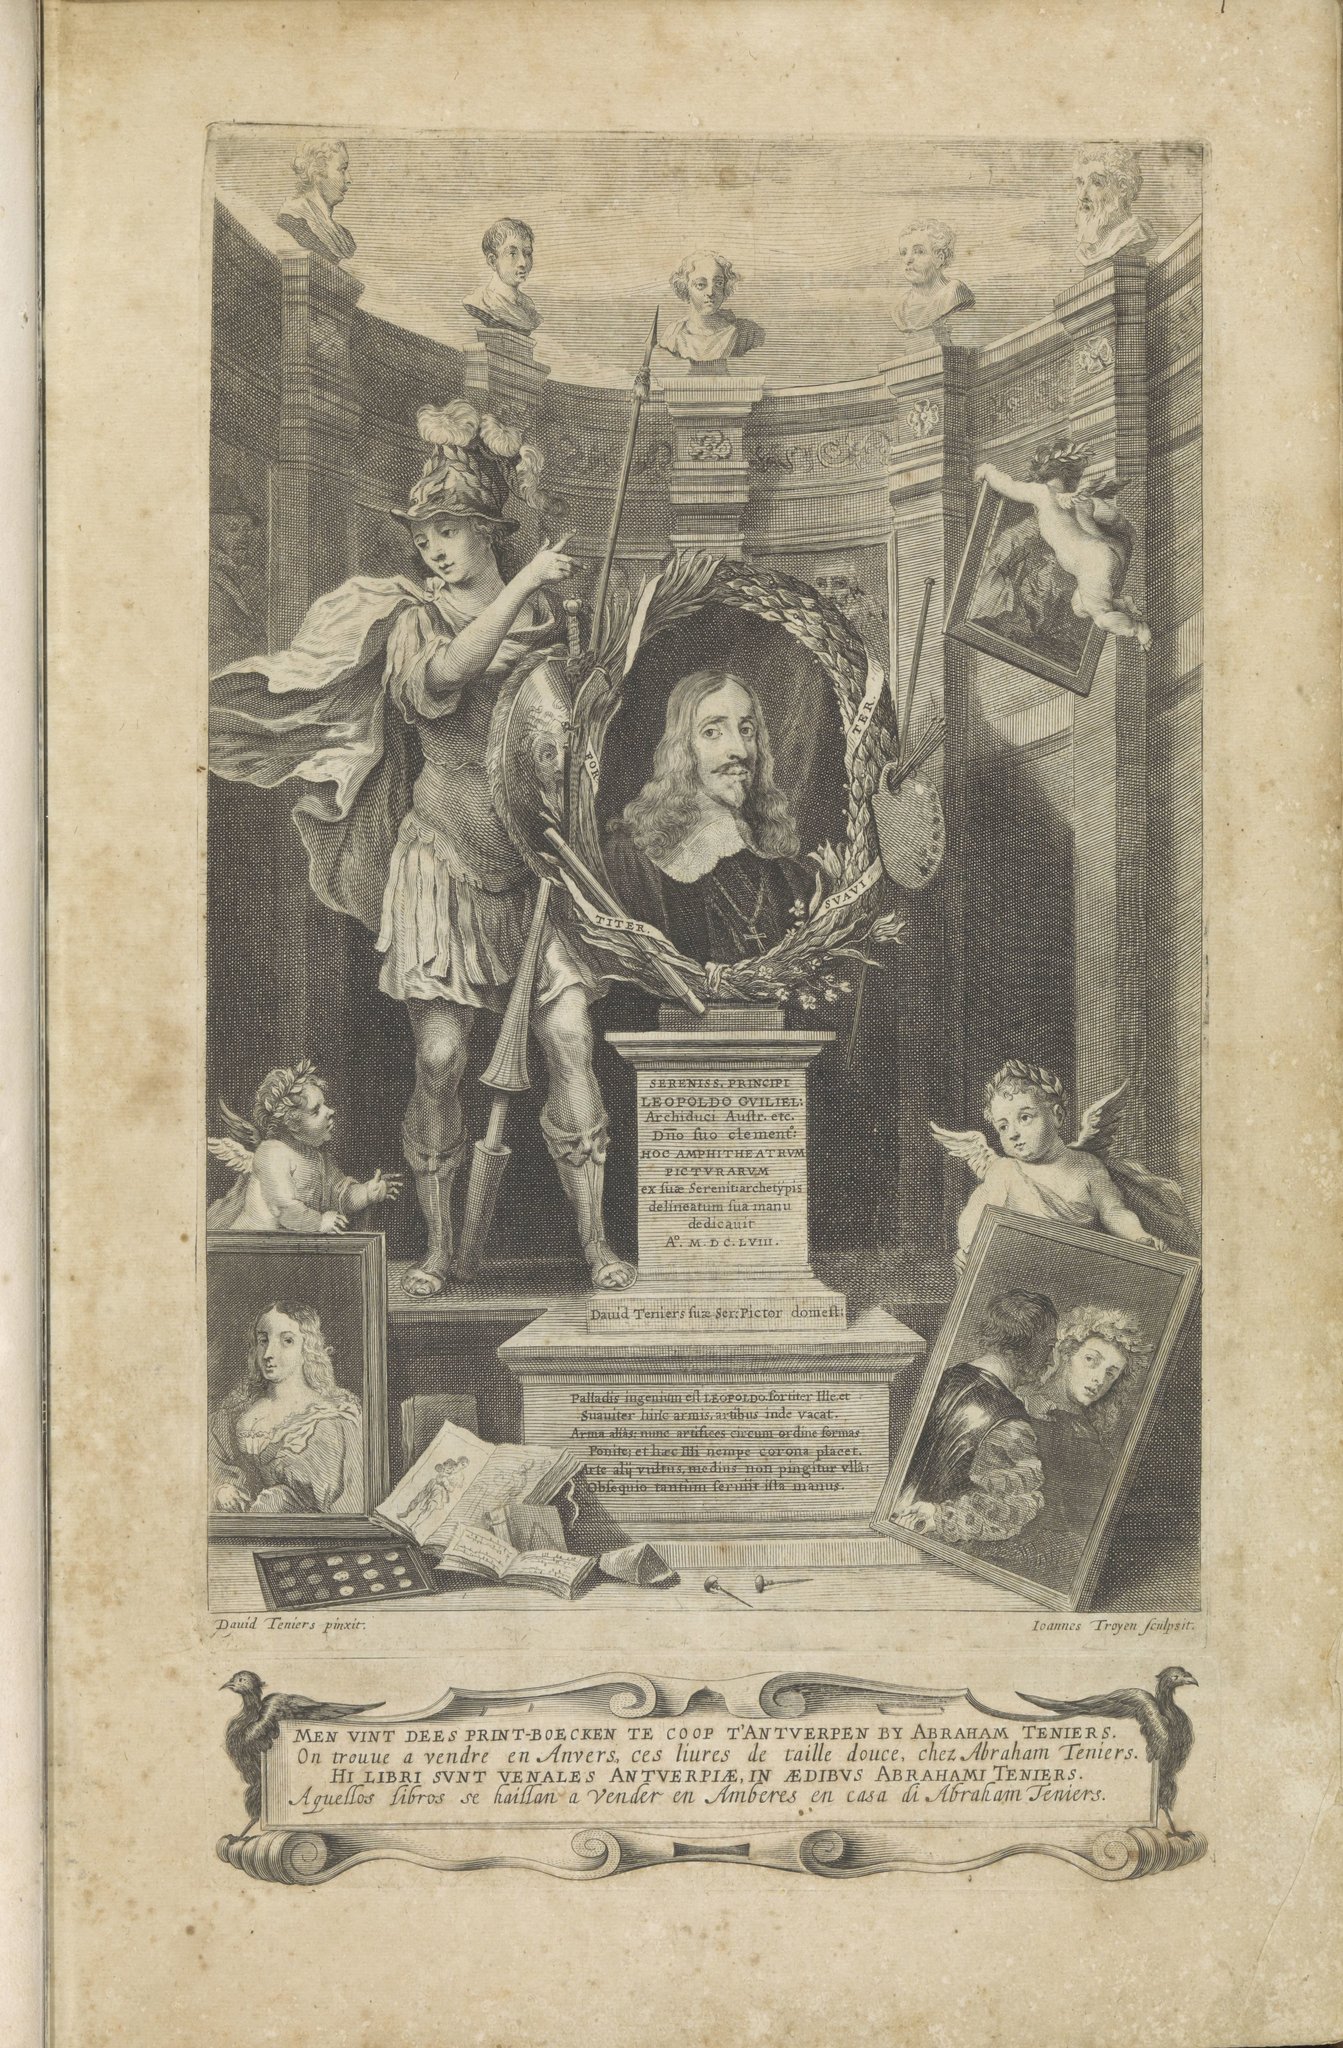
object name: print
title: Allegorie op aartshertog Leopold Willem van Oostenrijk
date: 1660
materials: paper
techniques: engraving, etching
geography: brussels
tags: vienna, leopold willem van oostenrijk (landvoogd der zuidelijke nederlanden), art (+ the work of art and its production), historical persons, specific aspects, allegorical aspects of minerva; minerva as patroness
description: De godin Minerva staat bij een portretbuste van aartshertog Leopold Willem van Oostenrijk op een sokkel. Rond het portret een lauwerkrans met schildersbenodigdheden, een vuurwapen en een tekstband met de Latijnse vertaling van 'krachtig' en 'innemend'; een verwijzing naar de titels van de twee schilderijen van Titiaan die vooraan door putti worden vastgehouden. Op de sokkel een tienregelige opdracht aan de aartshertog en een zesregelig lofdicht, beide in het Latijn. Op de achtergrond een klassiek gebouw met mannenbusten. Onderaan een reclame voor handelaar Abraham Teniers in vier talen. Deze prent maakt deel uit van een album.